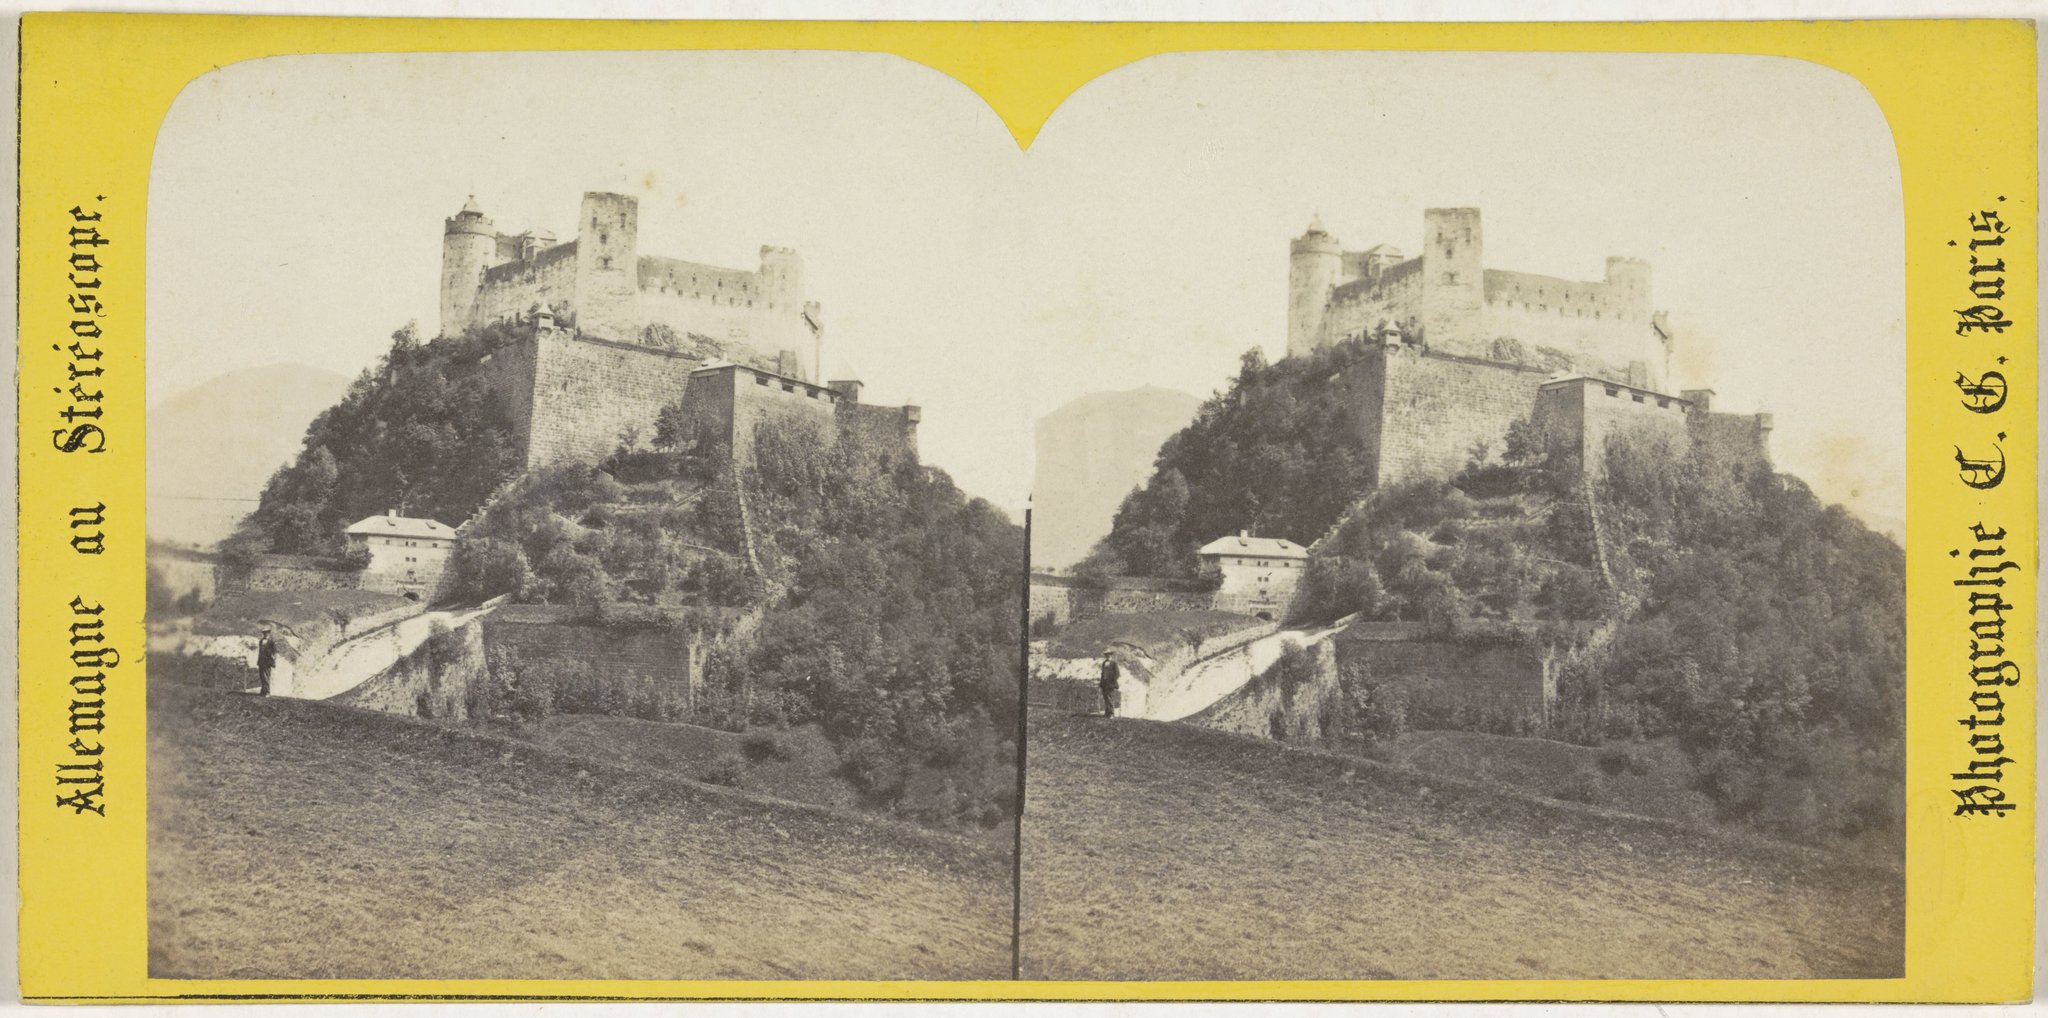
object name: stereograph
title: Gezicht op de vesting Hohensalzburg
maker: charles gaudin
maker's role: publisher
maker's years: 1825-1905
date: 1868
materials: cardboard, paper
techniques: albumen print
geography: salzburg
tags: castle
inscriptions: number: ‘69’, number: ‘60’, number: ‘69’, inscription: ‘a change’